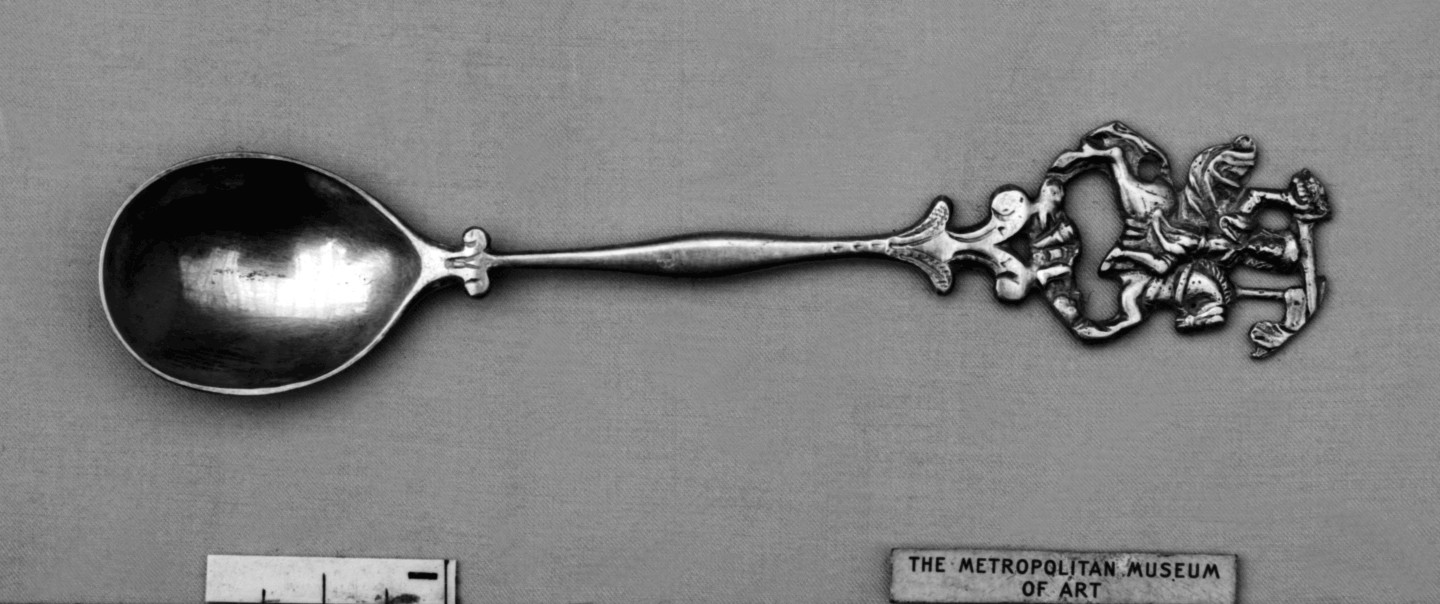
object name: spoon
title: Figure-top spoon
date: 1667-1700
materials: gilt, silver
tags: swords,men,horses